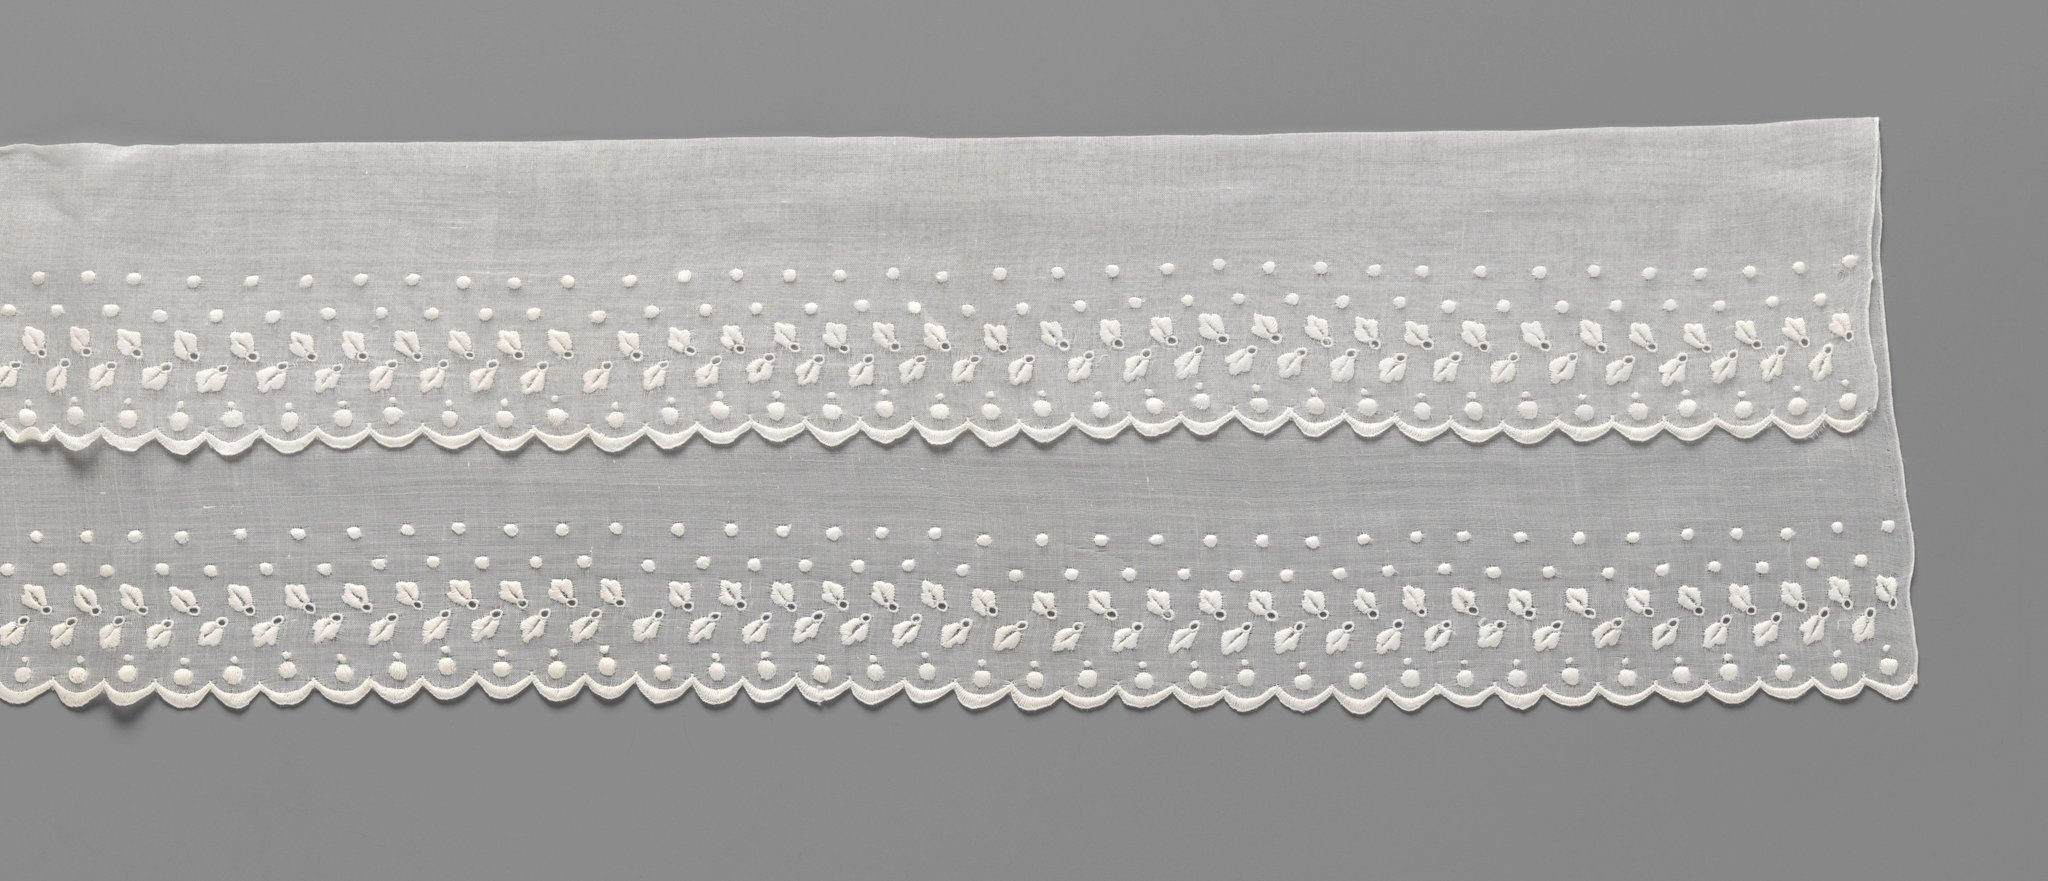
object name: strip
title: Strook glasbatist met witwerk met rijen blaadjes en stipjes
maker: Anonymous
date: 1850-1870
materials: cotton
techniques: embroidered, weave, embroidery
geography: switzerland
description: Japonstrook naturelkleurig glasbatist met witwerk. Langs boven- en onderrand loopt een schulpenrand met in elke schulp een stip met een klein stipje daarboven en verder naar boven twee rijen bladeren en twee rijen stippen. Aan elk blaadje zit in plaats van een steeltje een opengewerkt cirkeltje.